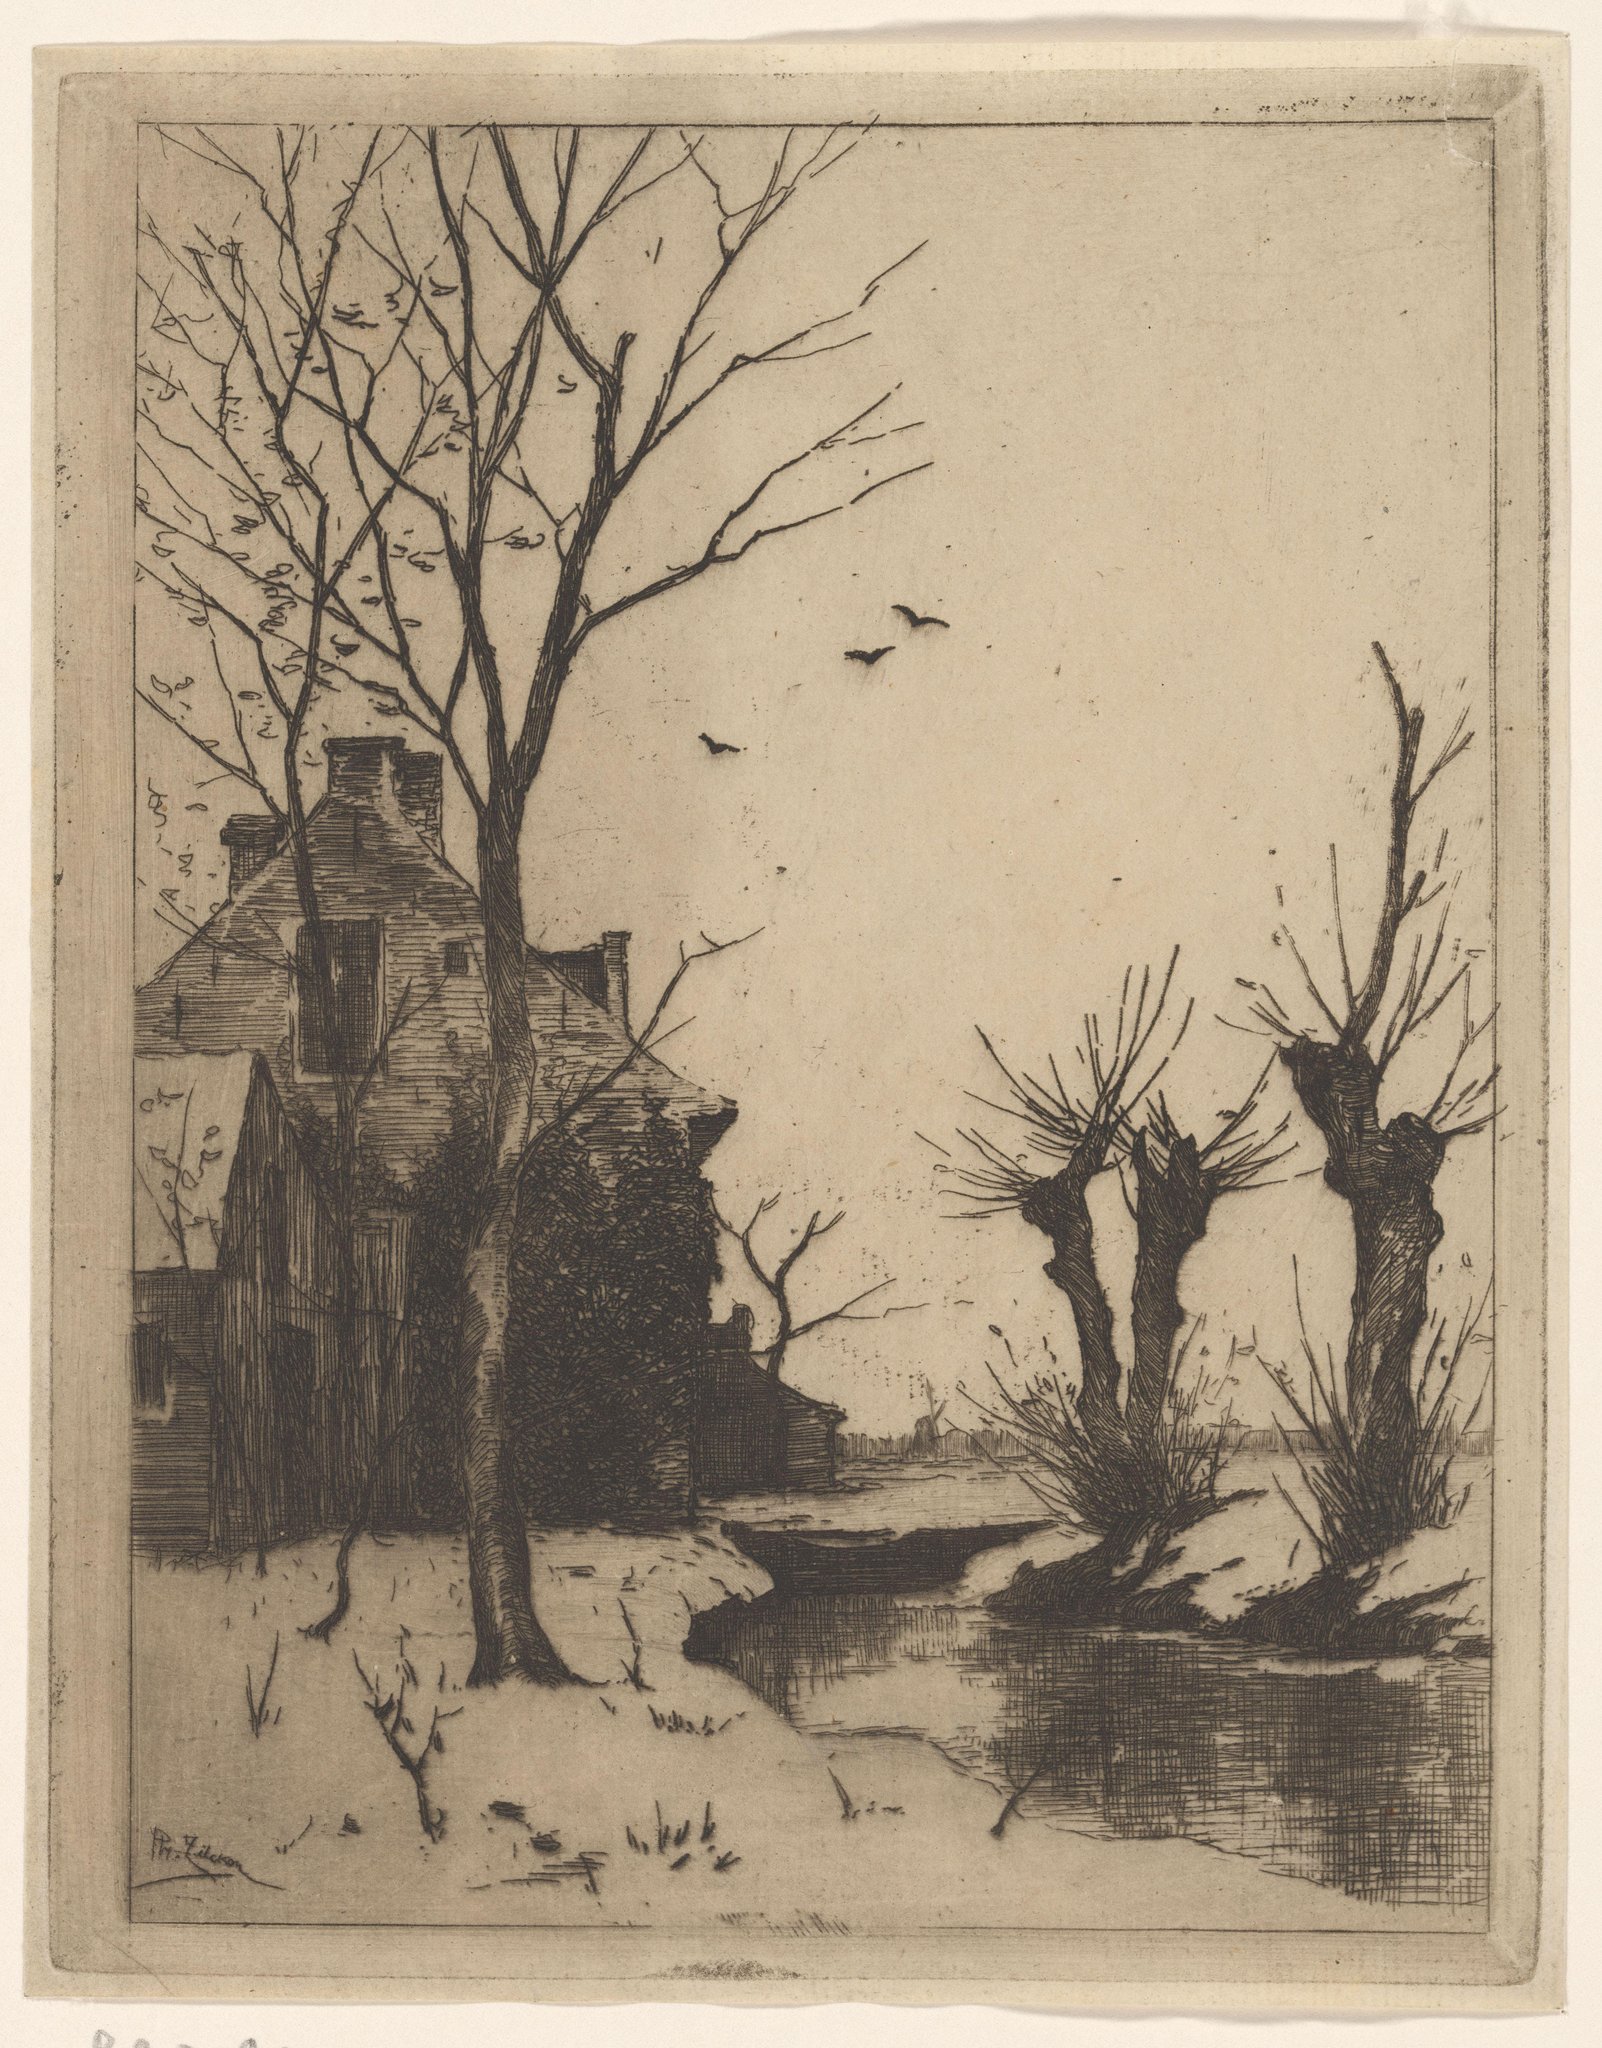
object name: print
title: Gezicht op een huis, sloot en knotwilgen in de sneeuw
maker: philip zilcken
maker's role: draughtsman, painter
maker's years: 1857-1930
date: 1867-1890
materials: paper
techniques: etching, intaglio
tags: rural housing, e.g. country-house, villa, cottage, trees: willow, small canal, ditch, the hague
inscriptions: collector's mark: Lugt 2233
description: Waarschijnlijk betreft het 'Het Kleine Loo' te Den Haag.